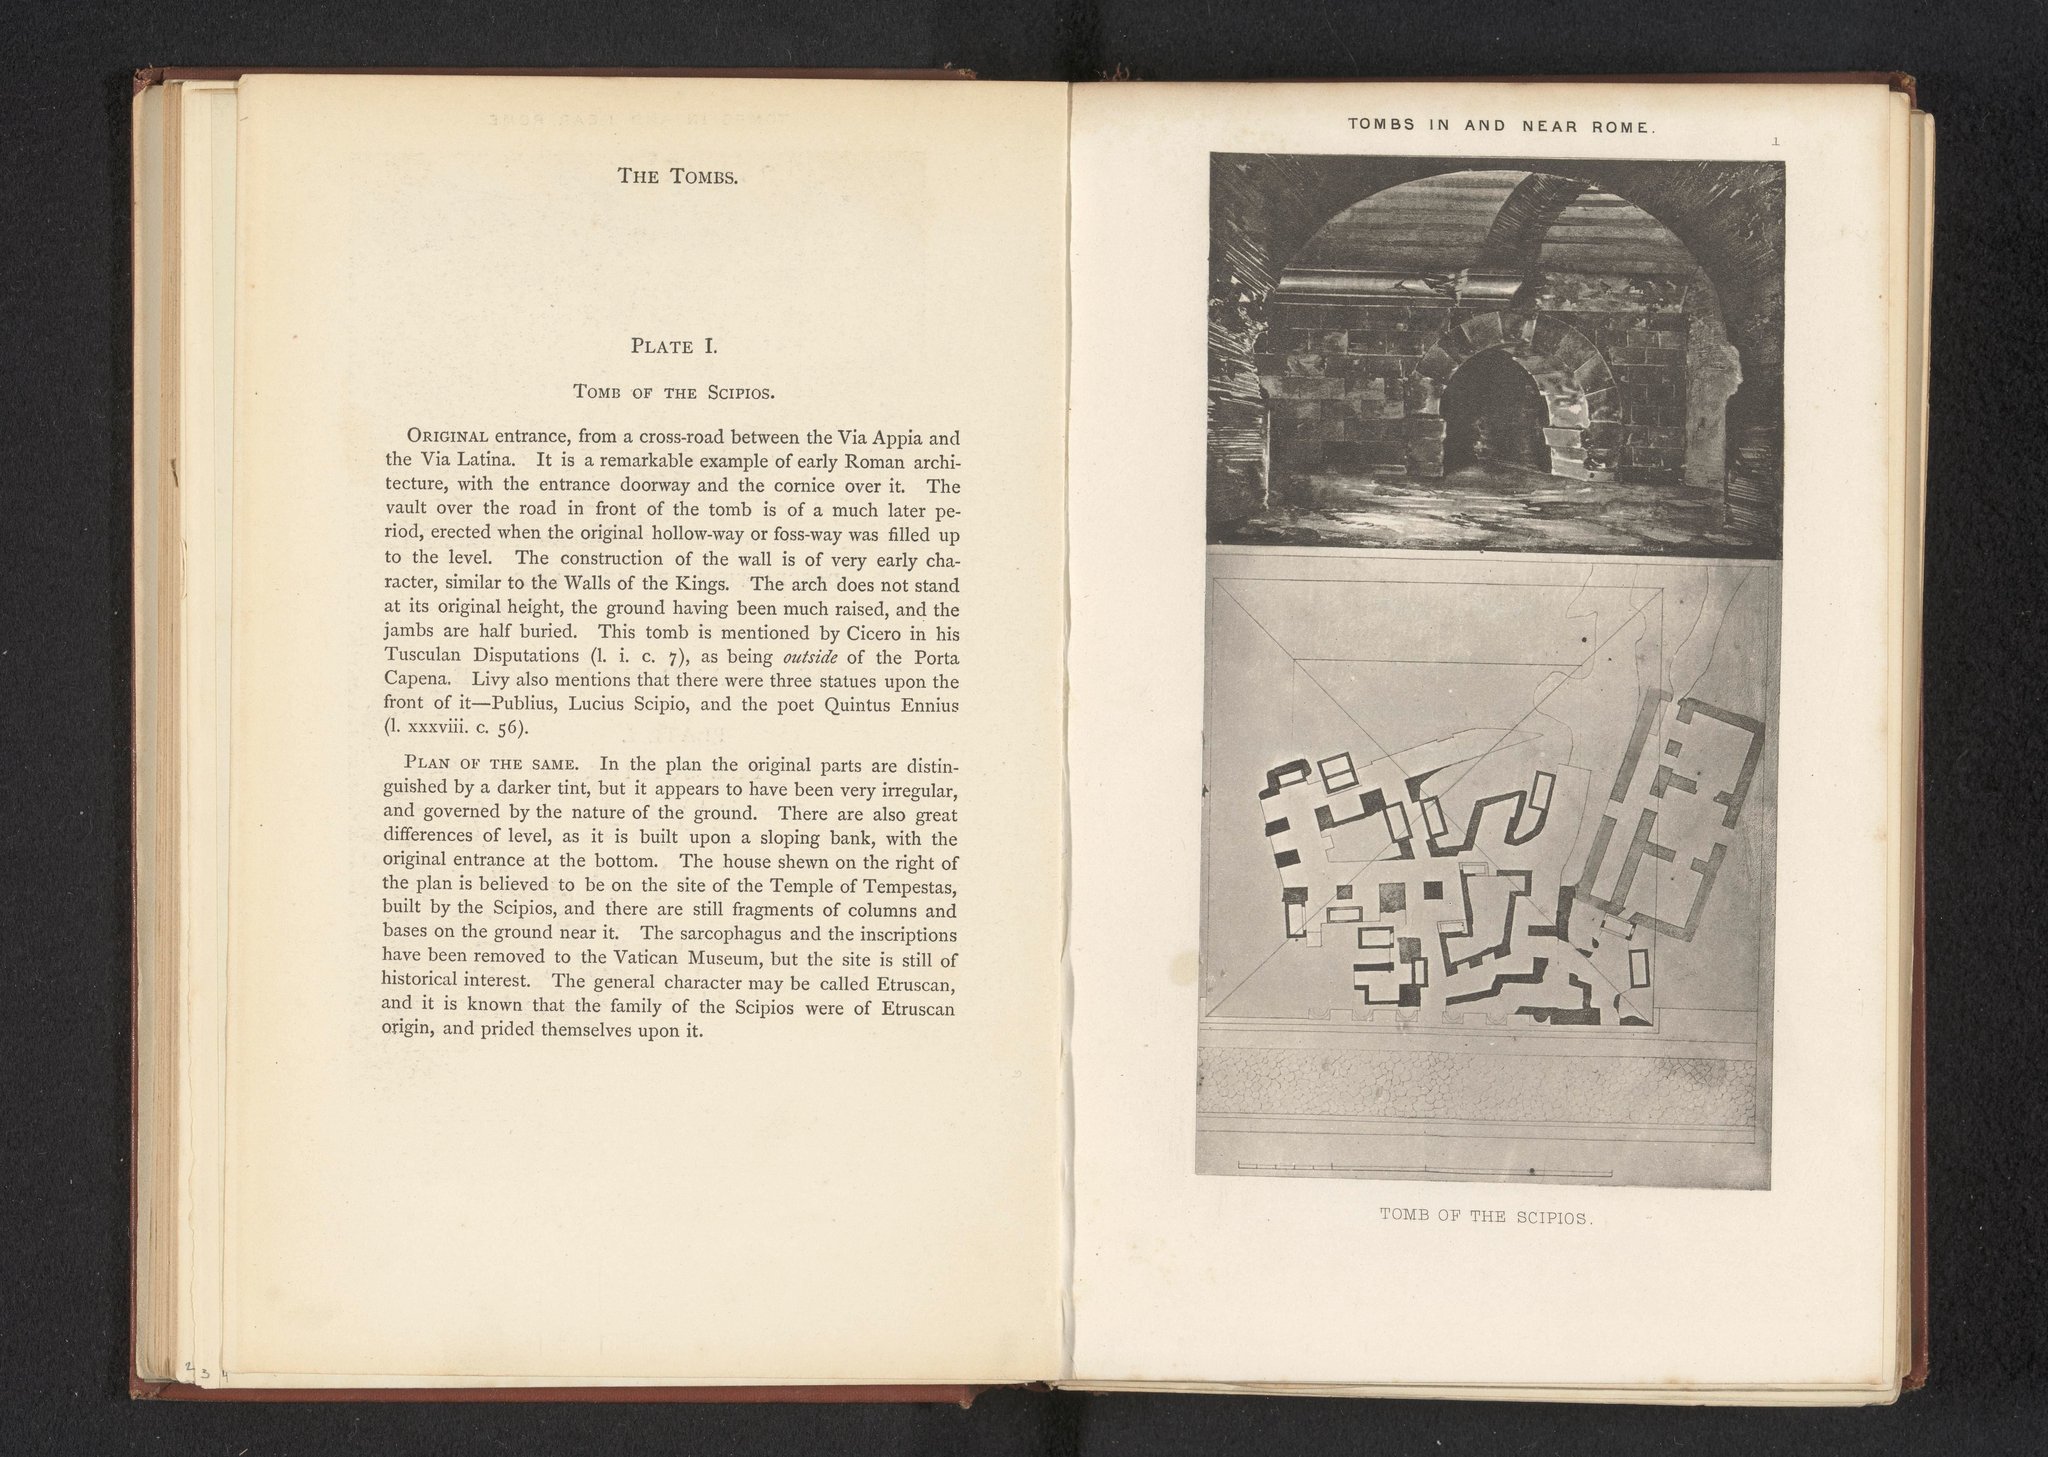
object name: reproduction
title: Interieur en een fotoreproductie van een plattegrond van de tombe van de Scipiones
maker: Anonymous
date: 1867-1877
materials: paper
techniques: photoaquatint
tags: grave, tomb, plan ~ architecture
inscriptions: number: ‘1’